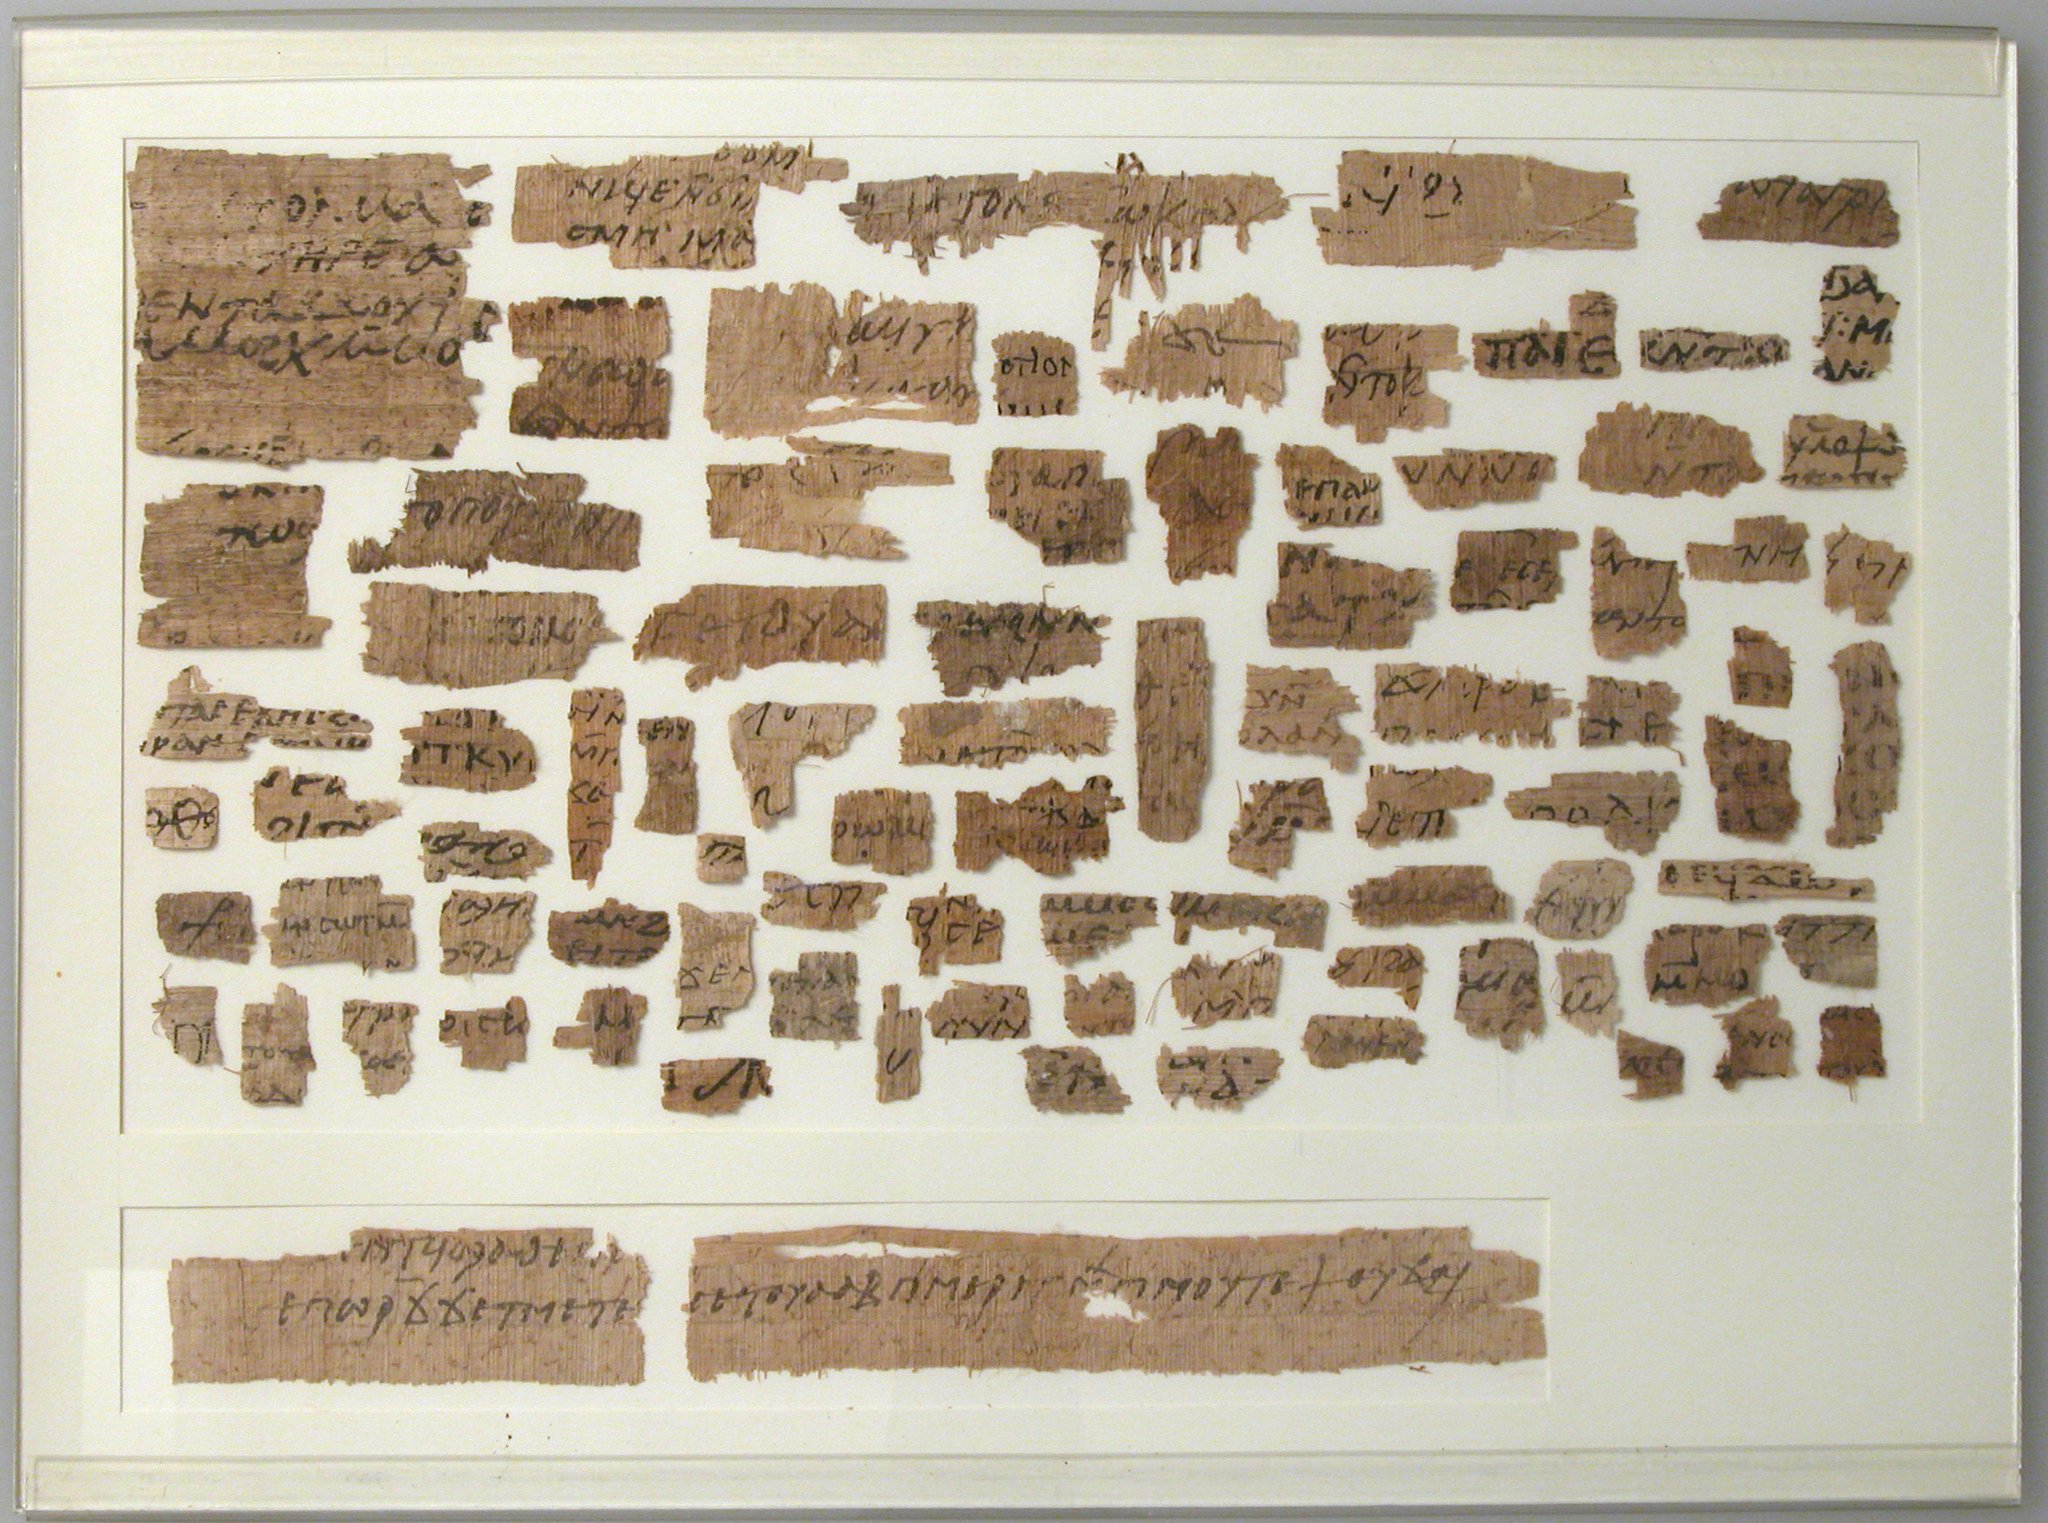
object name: fragment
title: Papyri Fragments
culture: coptic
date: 601-700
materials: ink, papyrus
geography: egypt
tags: documents